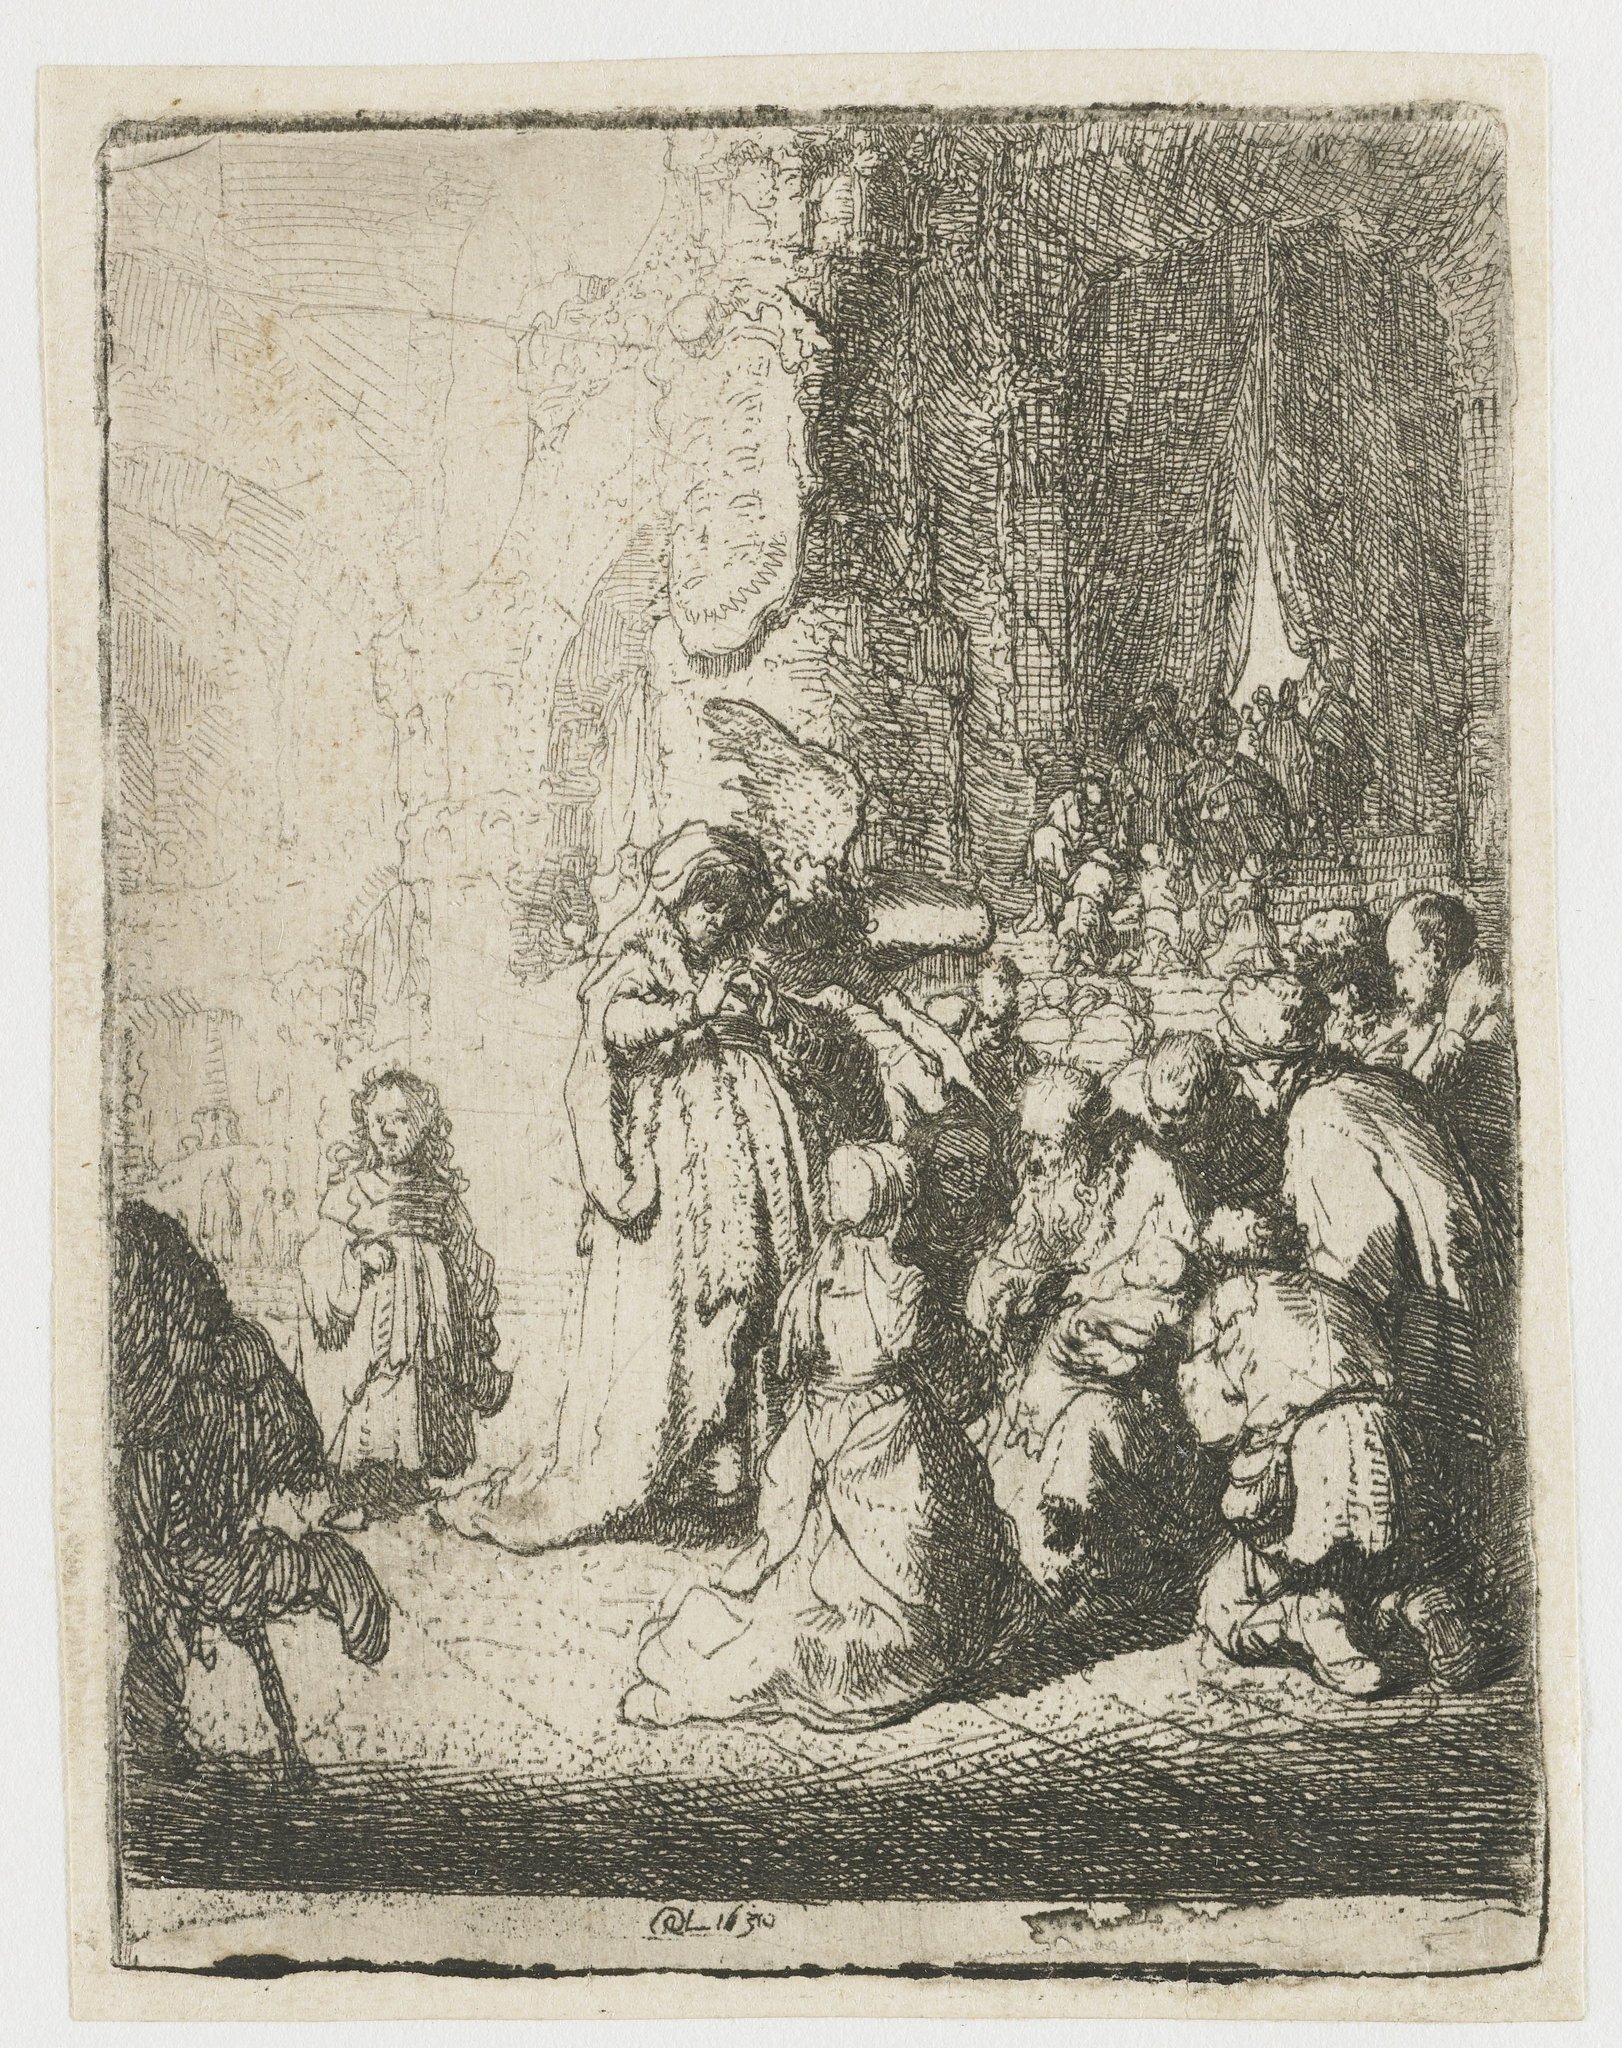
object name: print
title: Presentation in the temple with the angel: small plate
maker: rembrandt van rijn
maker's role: draughtsman, painter, print maker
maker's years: 1606-1669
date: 1630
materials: paper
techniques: etching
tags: simeon, holding the christ-child, sings his canticle: 'nunc dimittis'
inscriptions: monogram and date: ‘RHL 1630’, collector's mark: Lugt 240